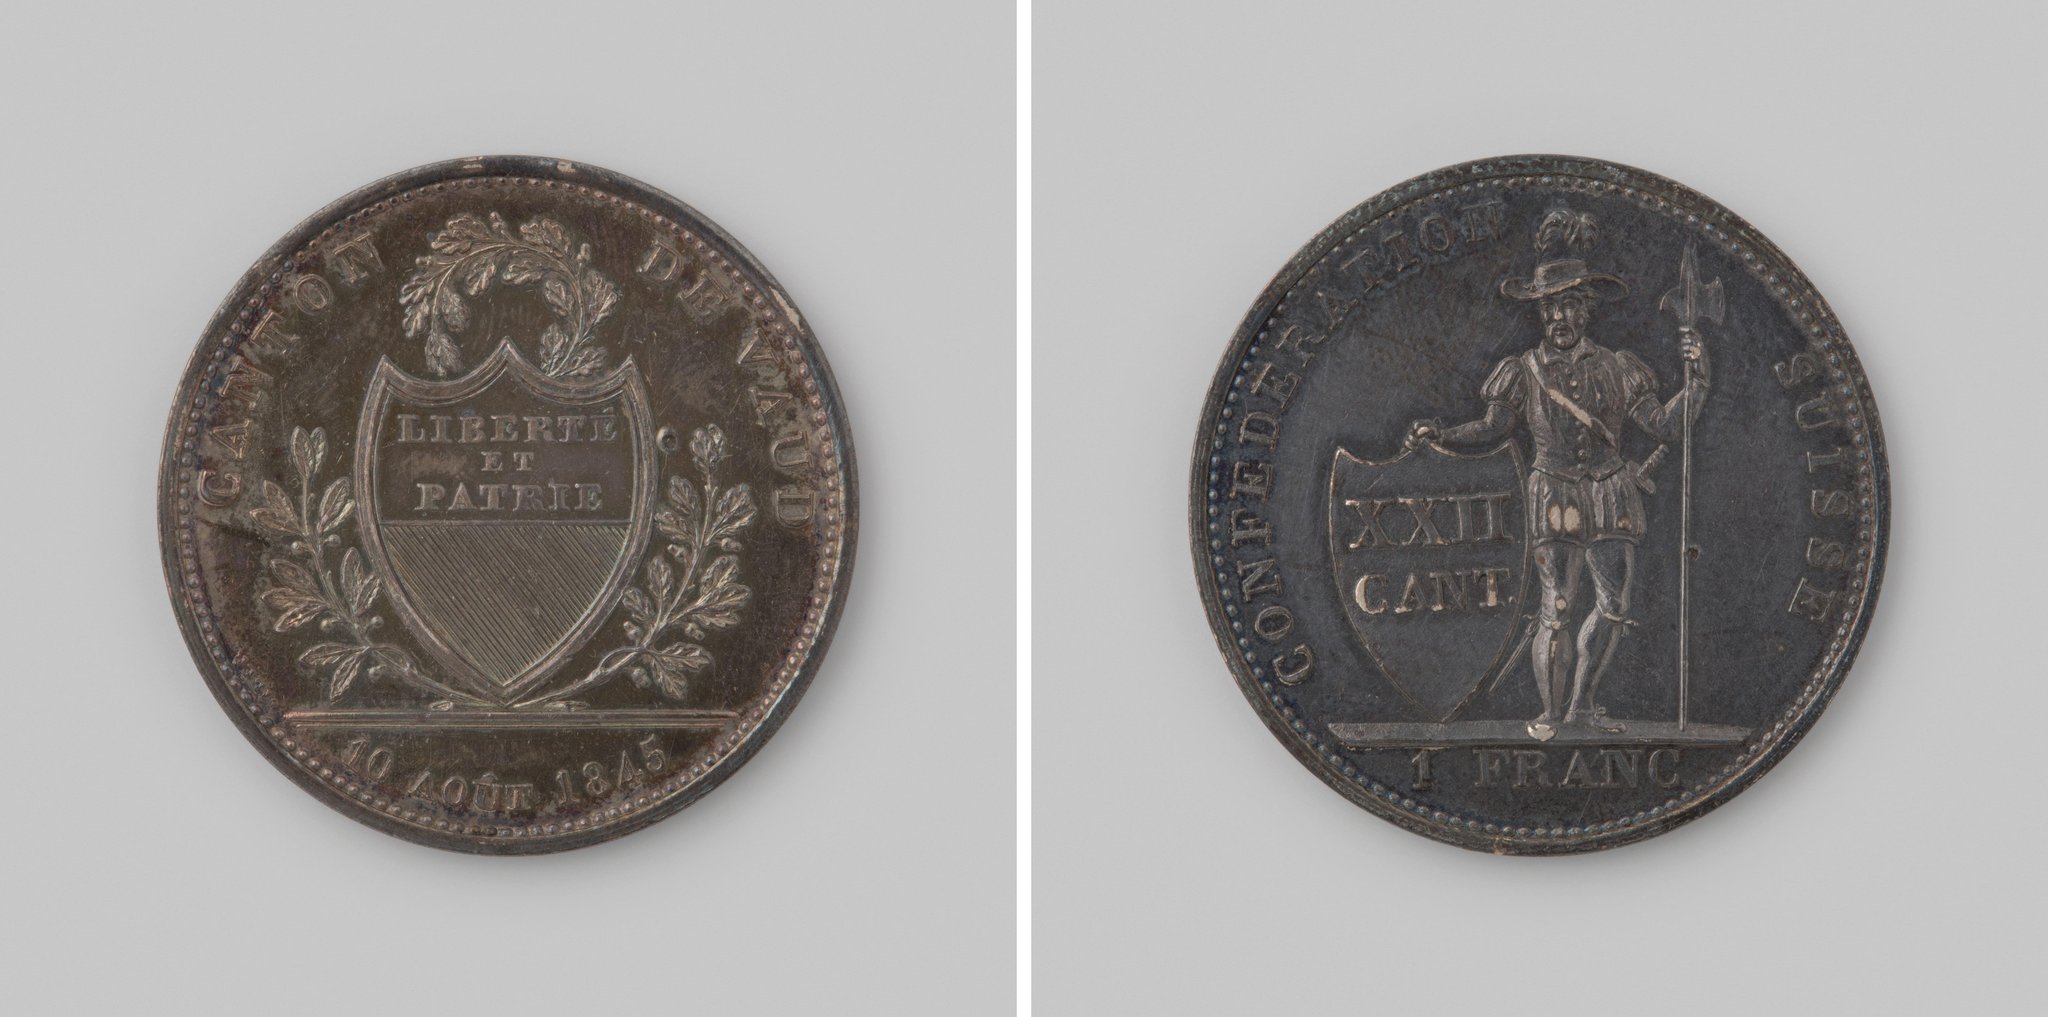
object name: coin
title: Franc uit het kanton Vaud, 1845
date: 1843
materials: silver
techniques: striking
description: Zilveren munt. Voorzijde: tussen twee takken wapenschild, waarboven rank. In afsnede jaartal met aanduiding: 10 aout. Keerzijde: staande man met hoed, waarop pluim. In zijn linkerhand een hellebaard en met zijn rechterhand een schild vasthoudend. Gladde rand.